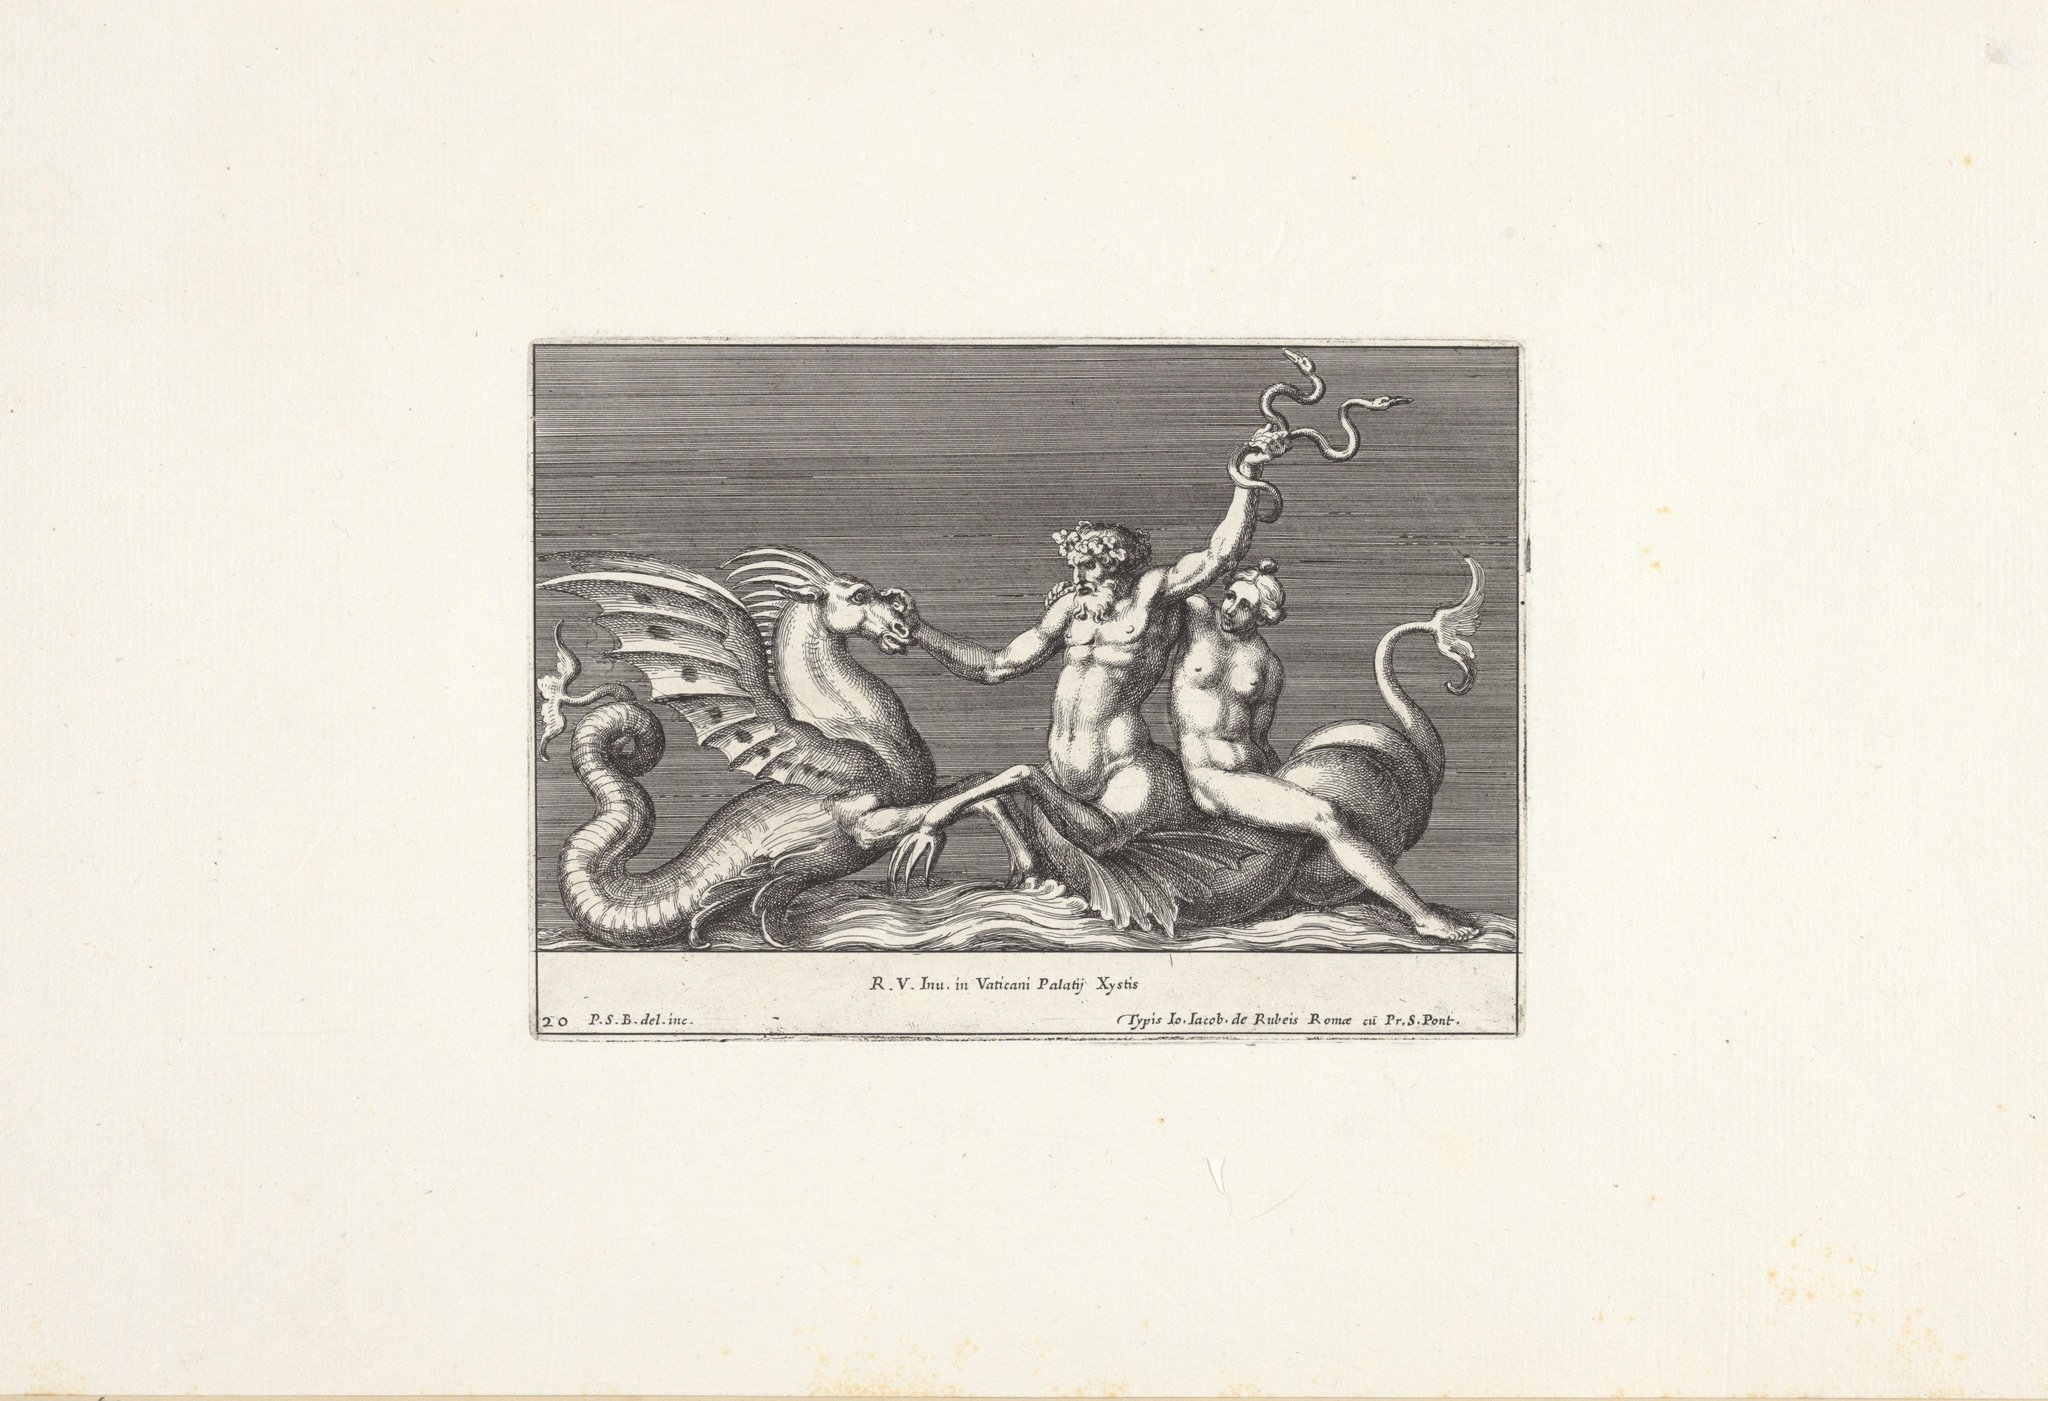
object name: print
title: Triton in gevecht met een zeemonster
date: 1645-1700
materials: paper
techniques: engraving, etching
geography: vatican city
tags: triton(s), monsters of the sea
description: Prent uit een reeks naar de gipsen reliëfs door Rafaël en uitgevoerd door zijn assistenten in de Vaticaanse Loggia.